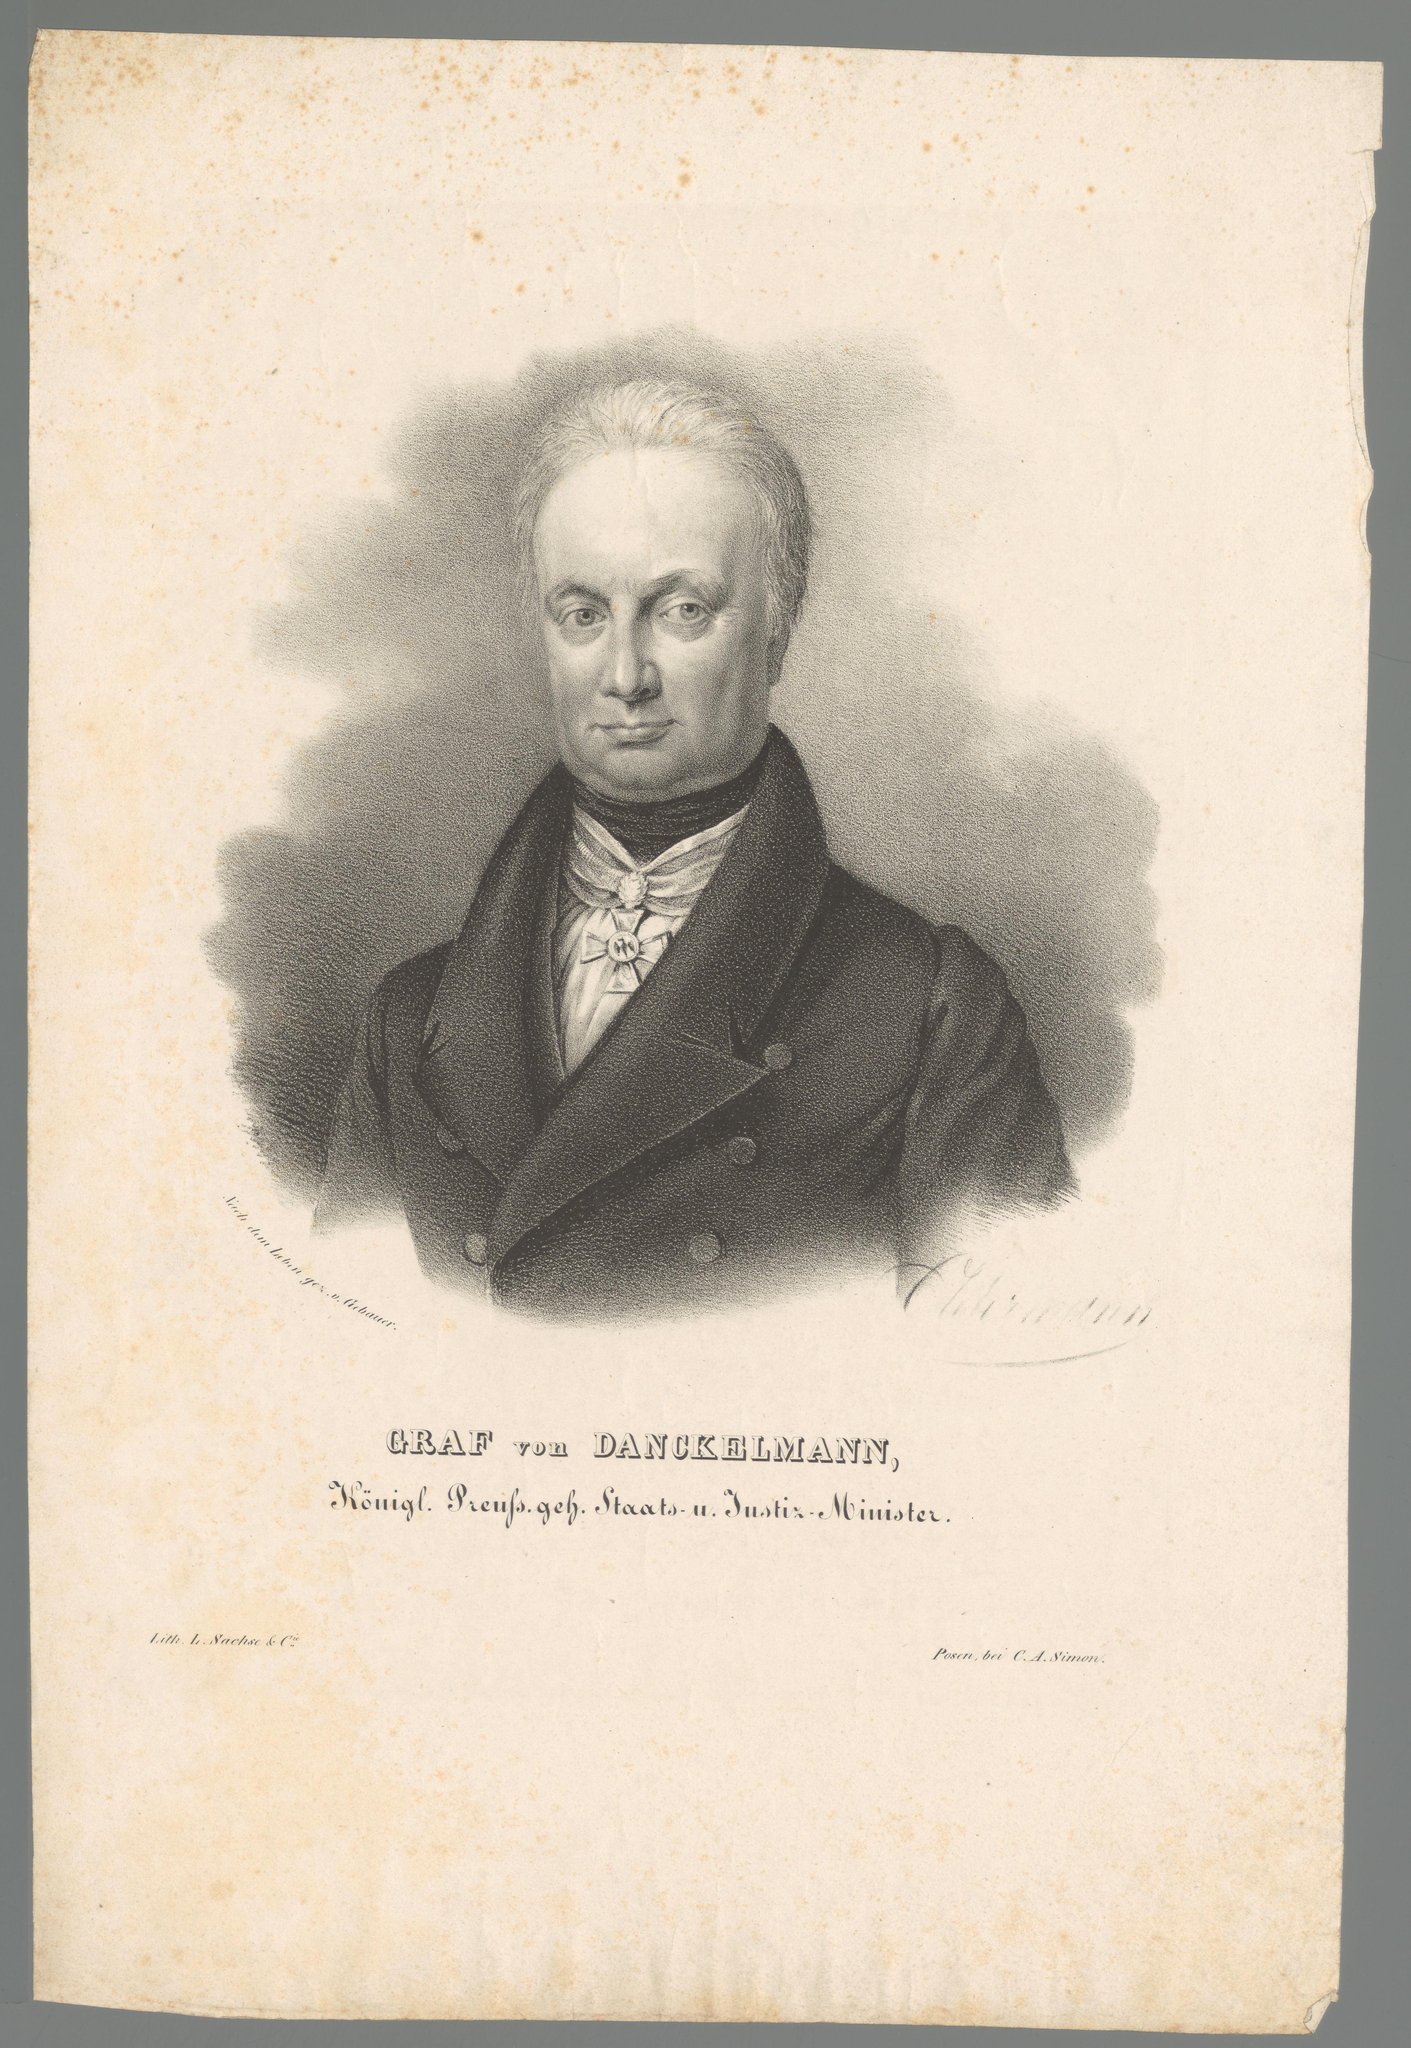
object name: print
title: Portret van Heinrich, graaf van Danckelmann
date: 1832-1854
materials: paper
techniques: lithograph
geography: berlin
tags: cleves, adult man, historical persons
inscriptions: mark, collector's mark: Lugt 2228